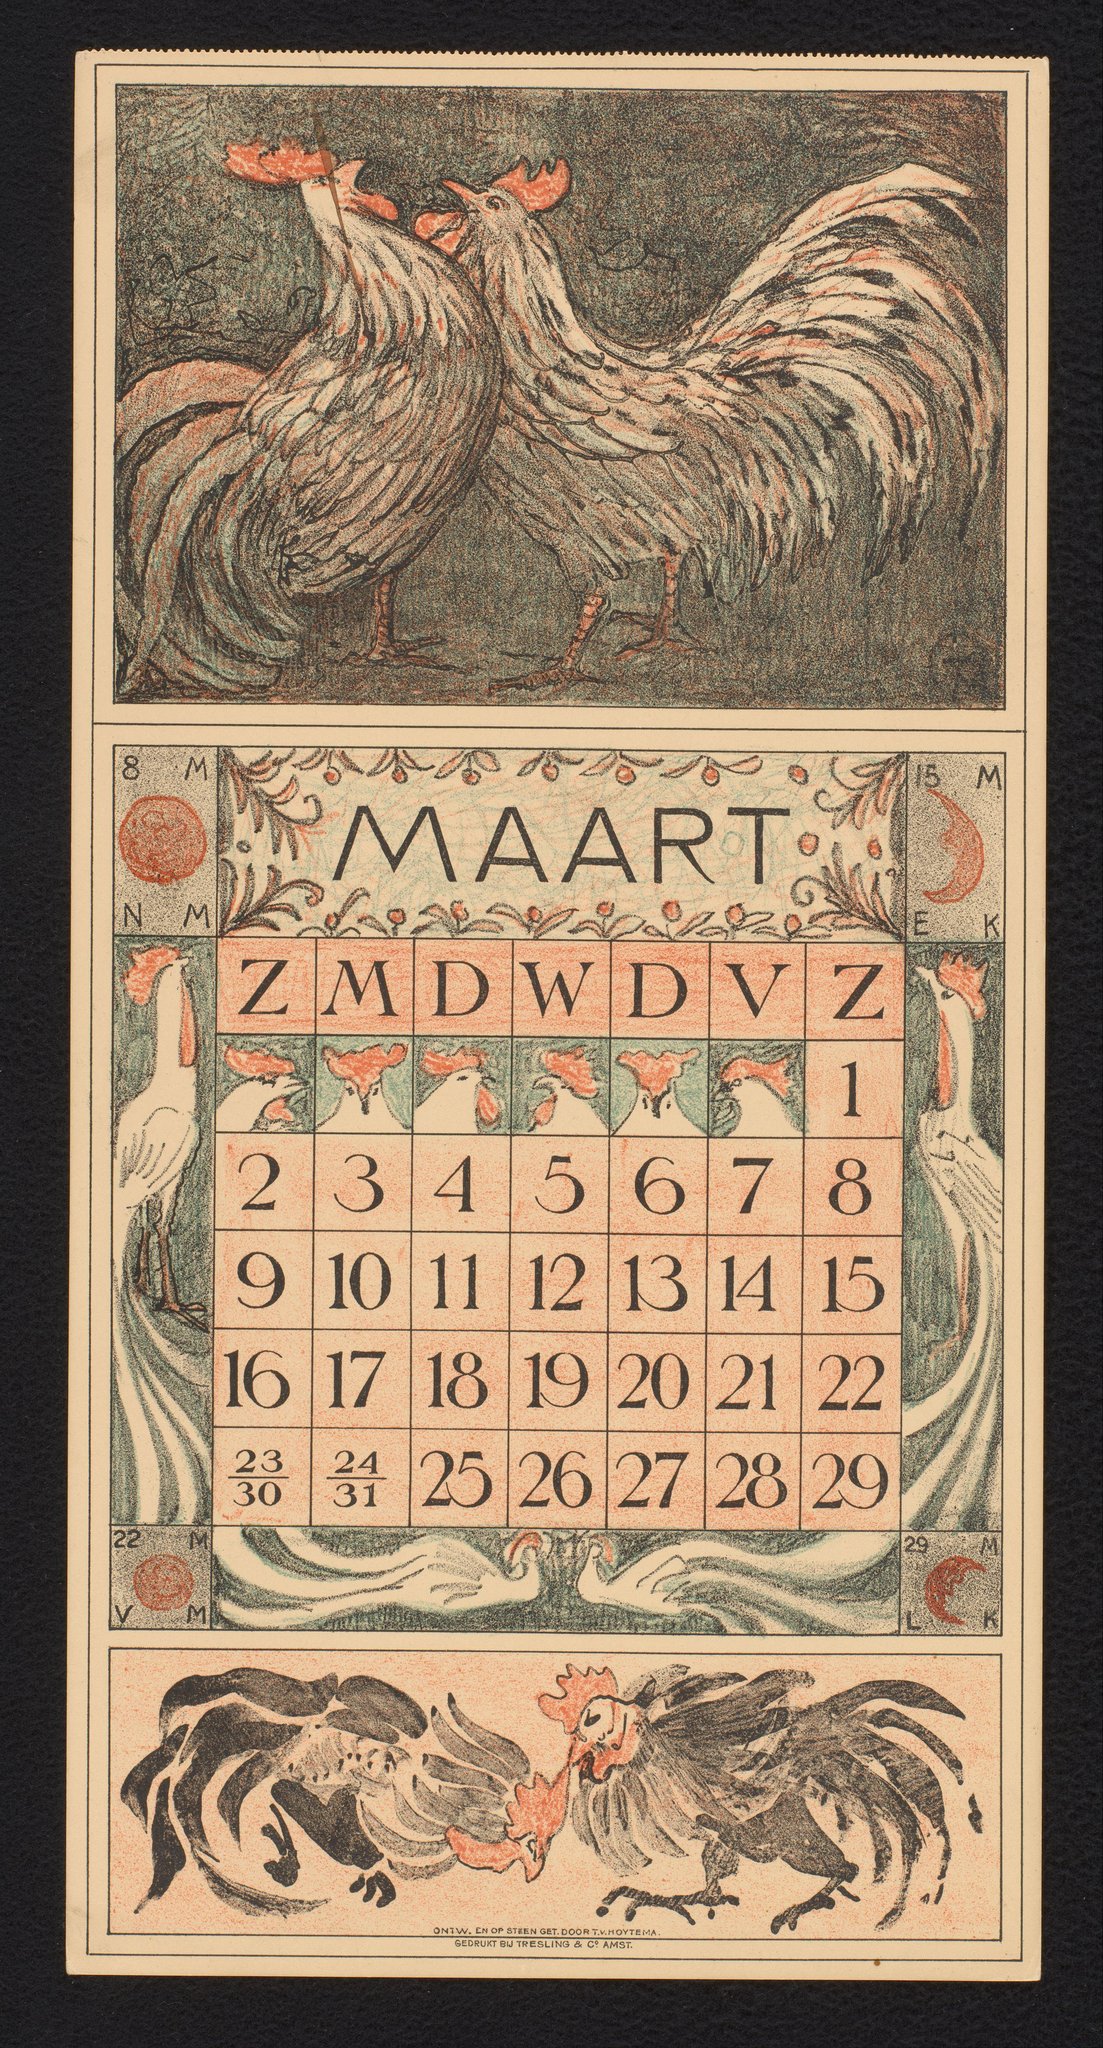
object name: print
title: Kalenderblad voor maart 1913 met hanen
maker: theo van hoytema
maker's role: draughtsman, painter, print maker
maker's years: 1863-1917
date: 1912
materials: paper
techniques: lithograph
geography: amsterdam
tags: fowl (cock, hen, chicken, etc.)